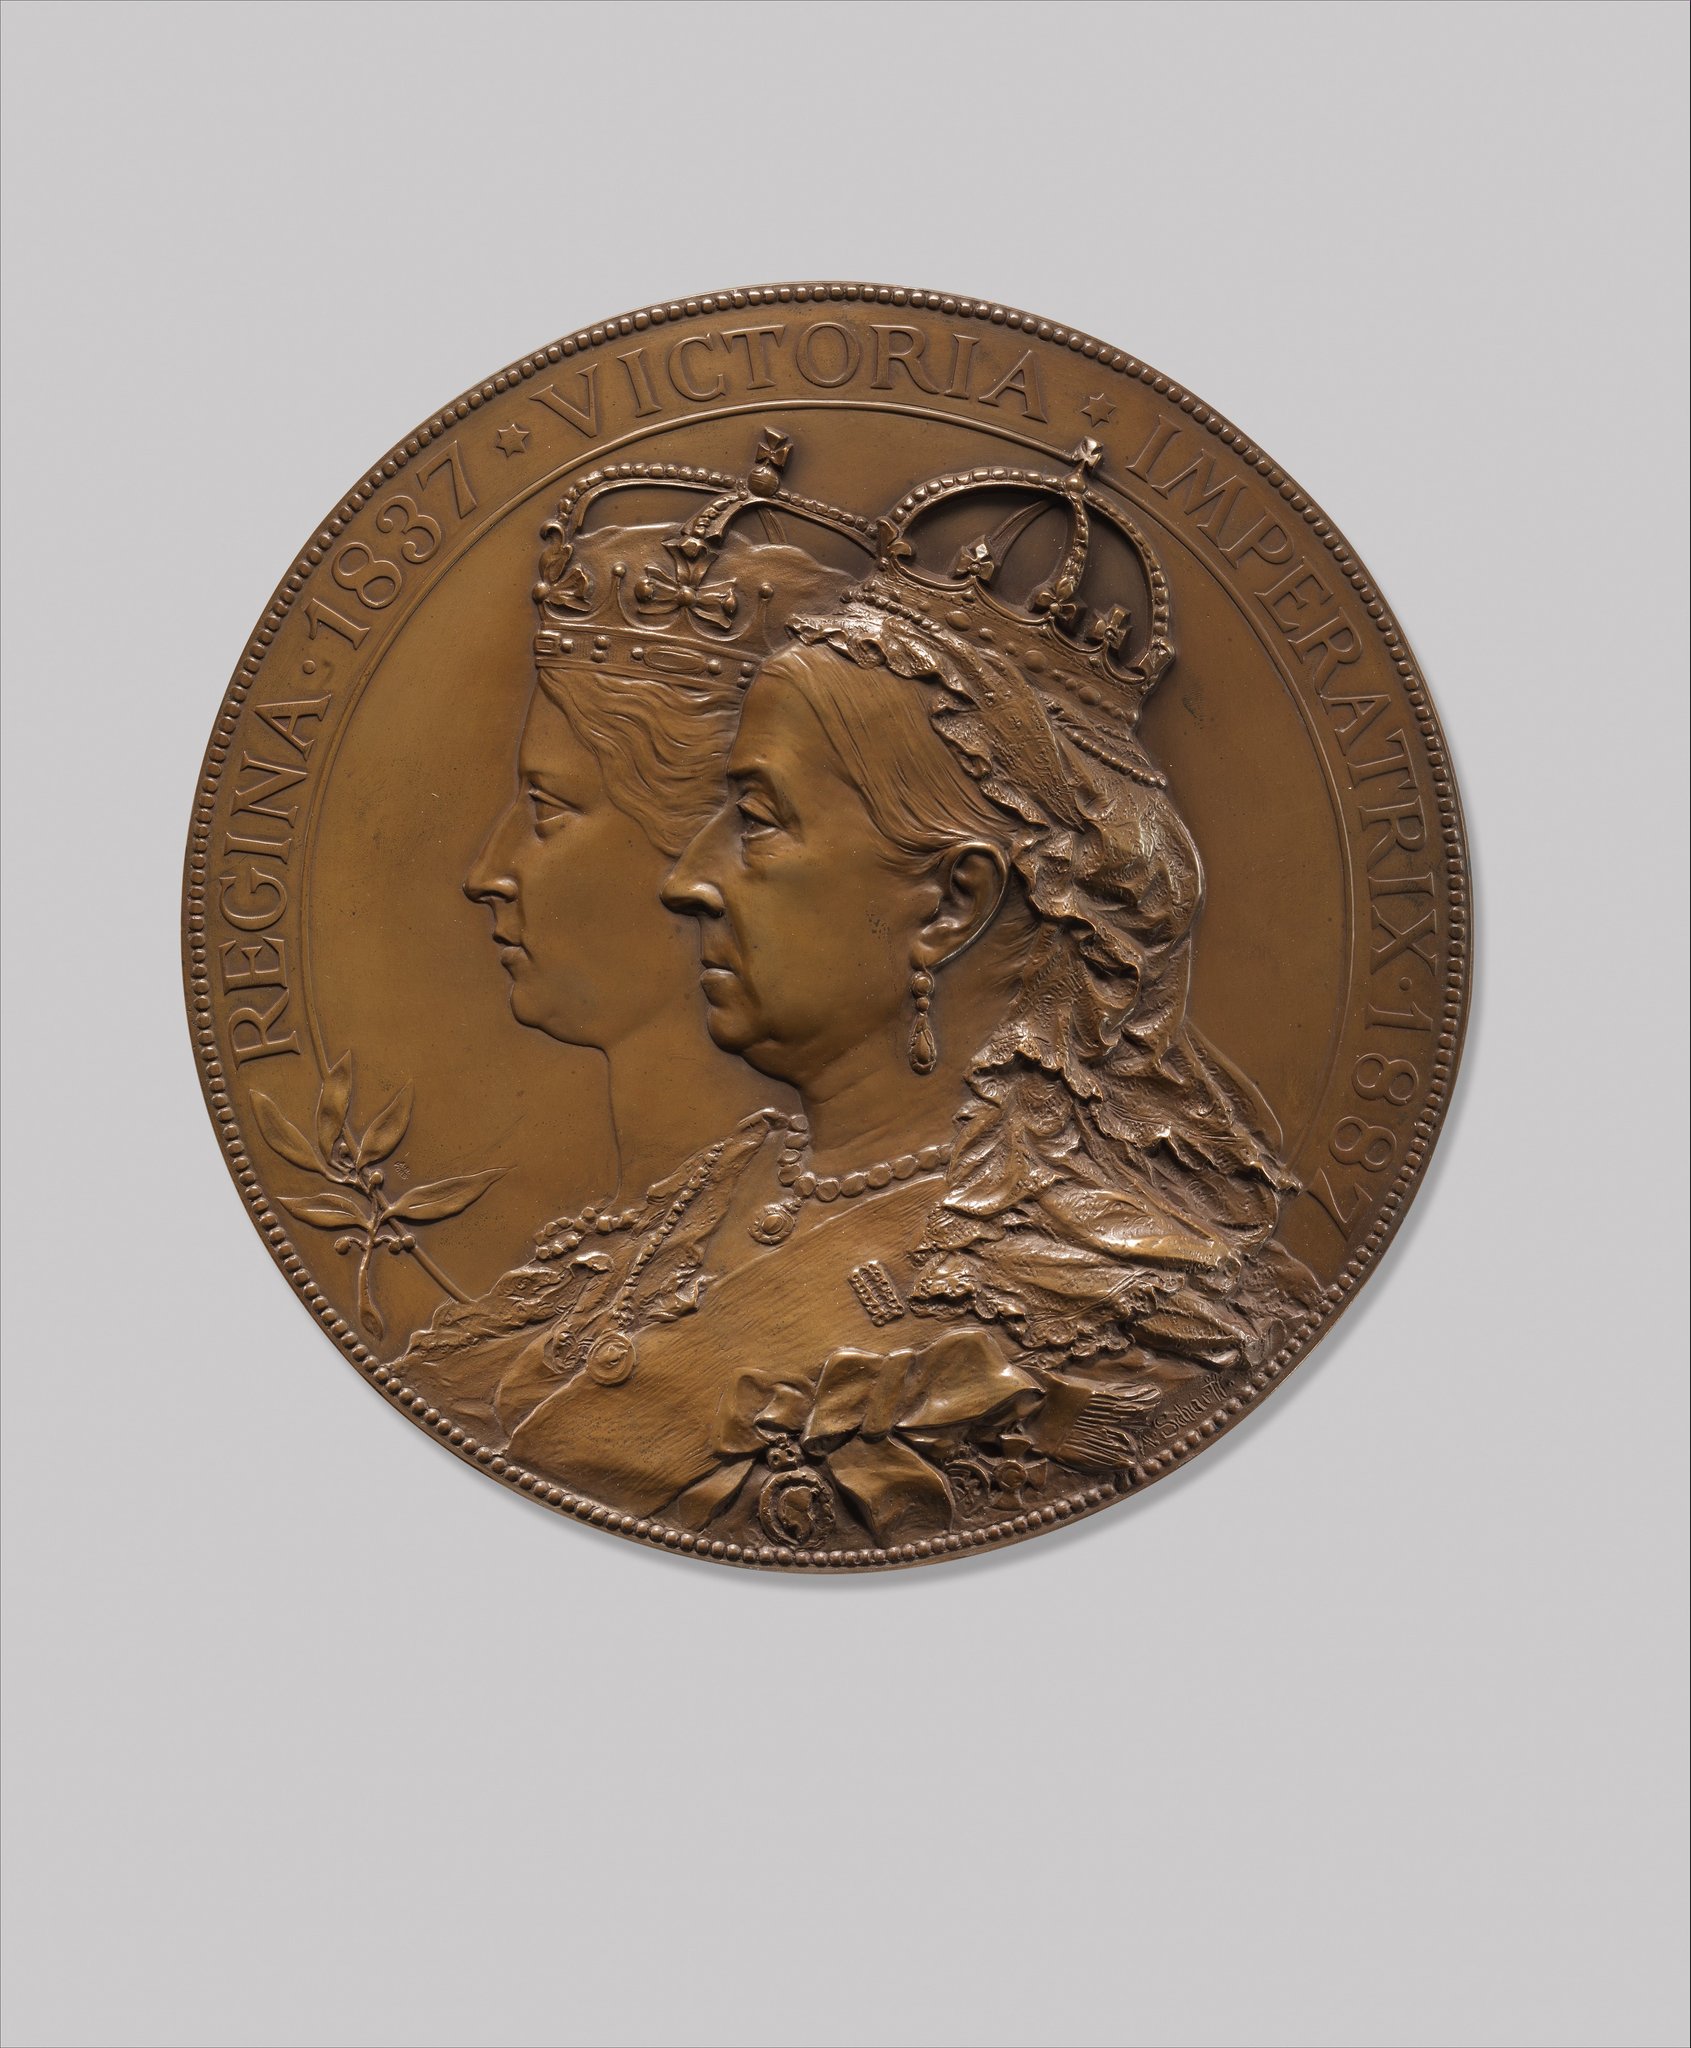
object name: medallion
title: Queen Victoria’s Jubilee, 1887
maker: anton scharff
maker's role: artist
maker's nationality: austrian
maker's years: 1845-1903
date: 1887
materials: bronze, patina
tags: queens,women,queen victoria